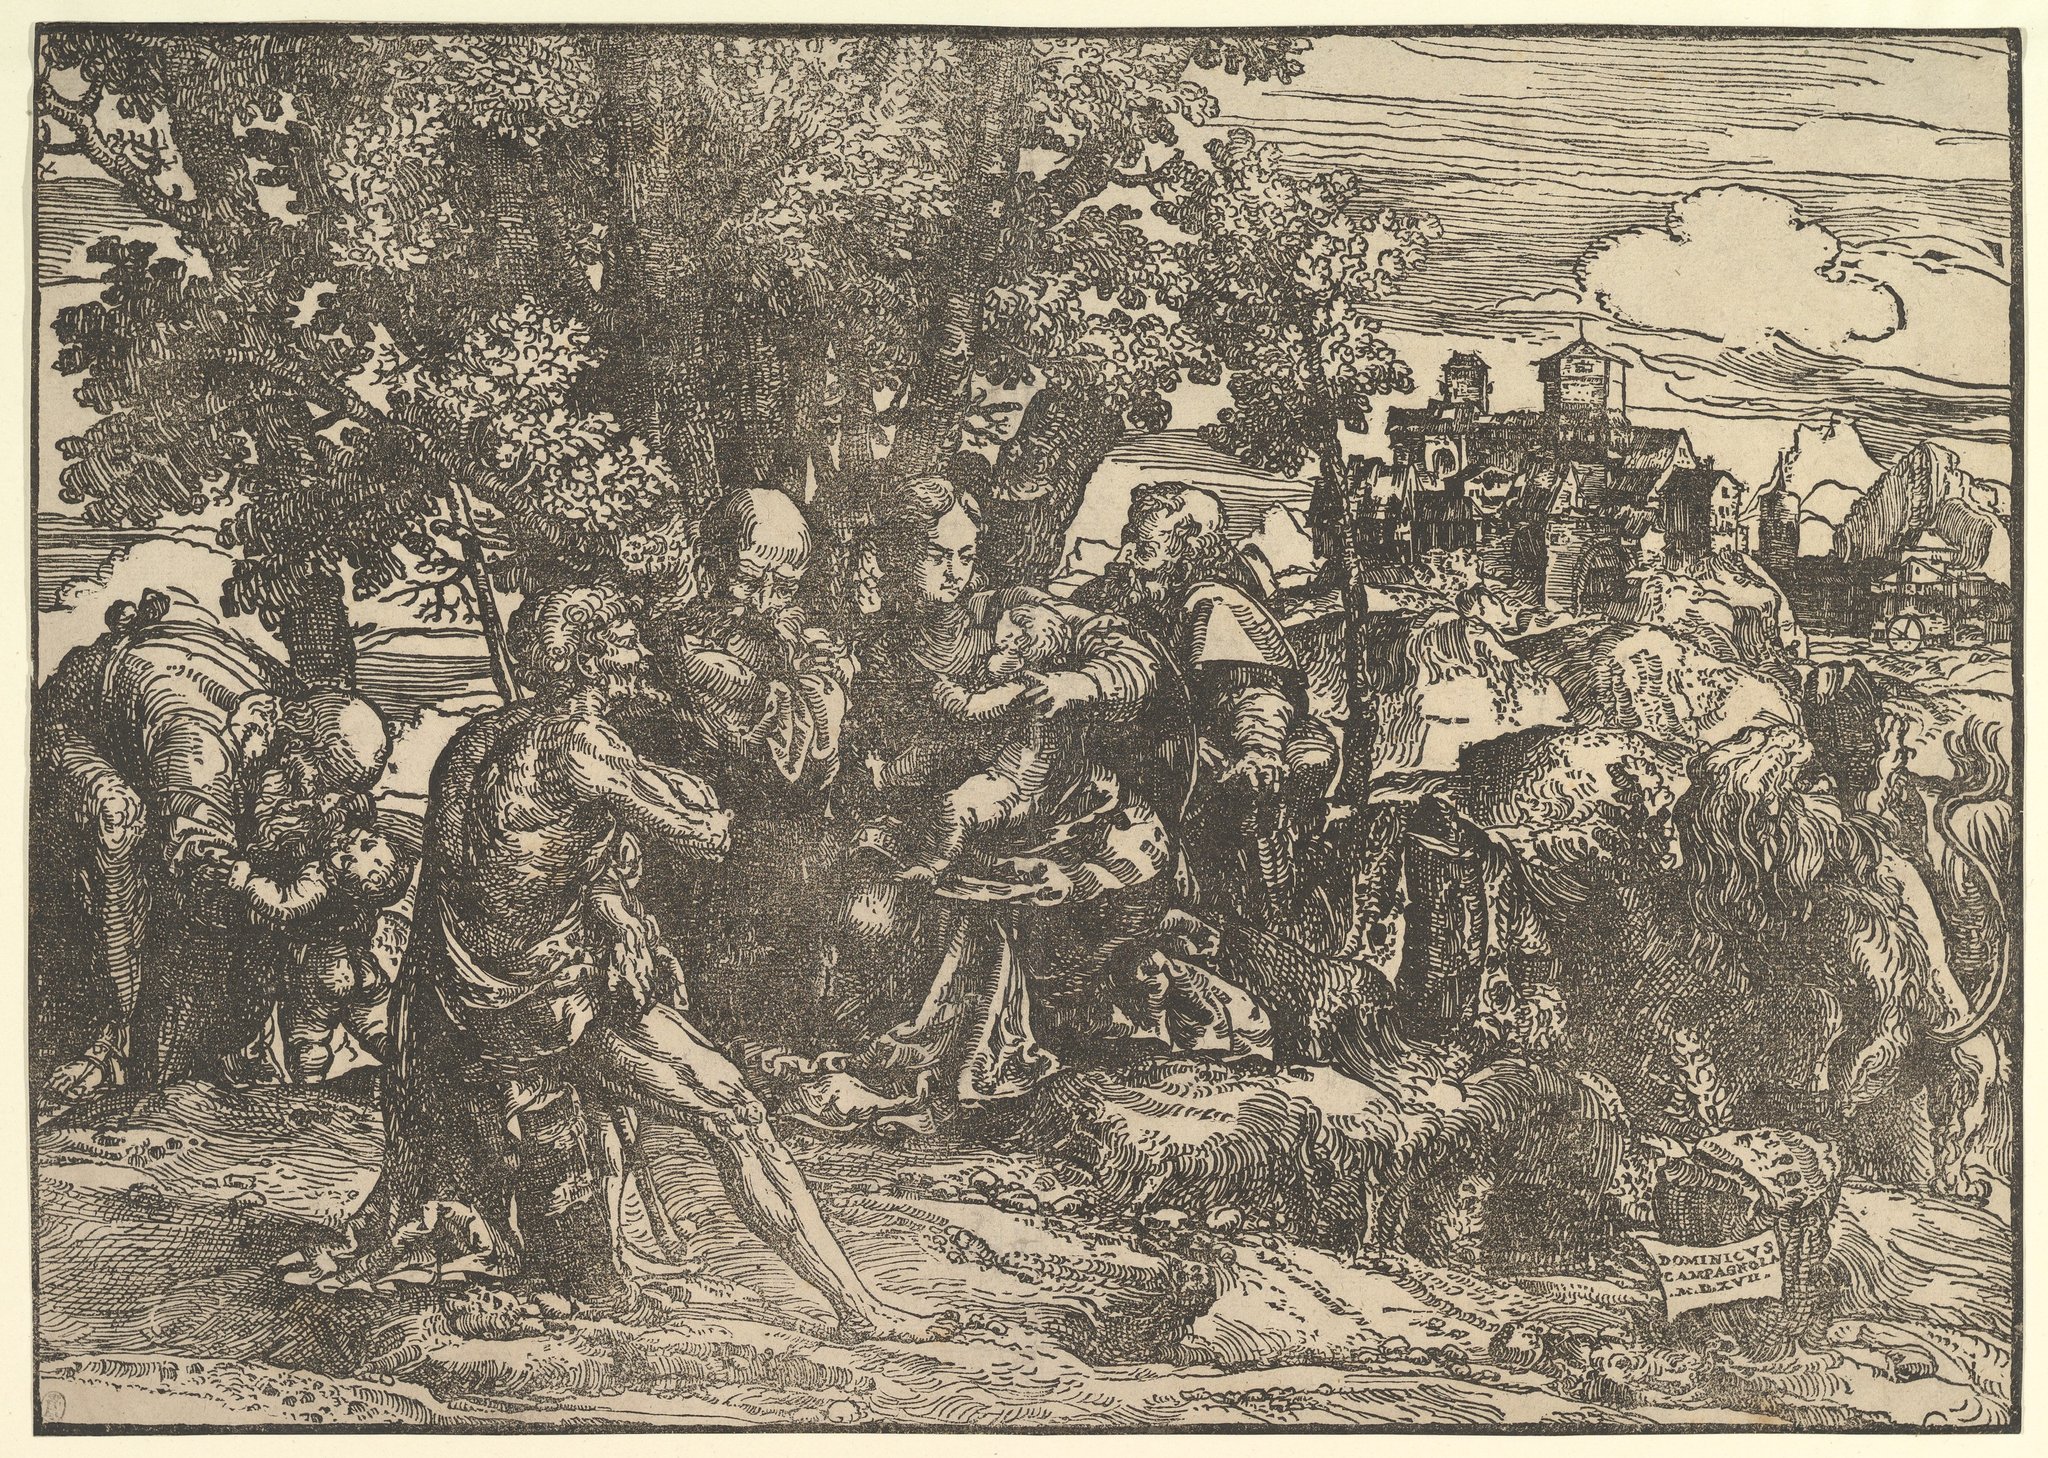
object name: print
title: Mary seated beneath trees with baby, flanked by Joseph at left and St. Jerome at right; St. John the Baptist seated in the foreground holding a cross; a man stooping to pick up a child at left; a lion seen from behind at right; a town in the background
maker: domenico campagnola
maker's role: artist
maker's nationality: italian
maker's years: 1500-1564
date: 1517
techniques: woodcut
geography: venice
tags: infants,men,trees,saint john the baptist,virgin mary